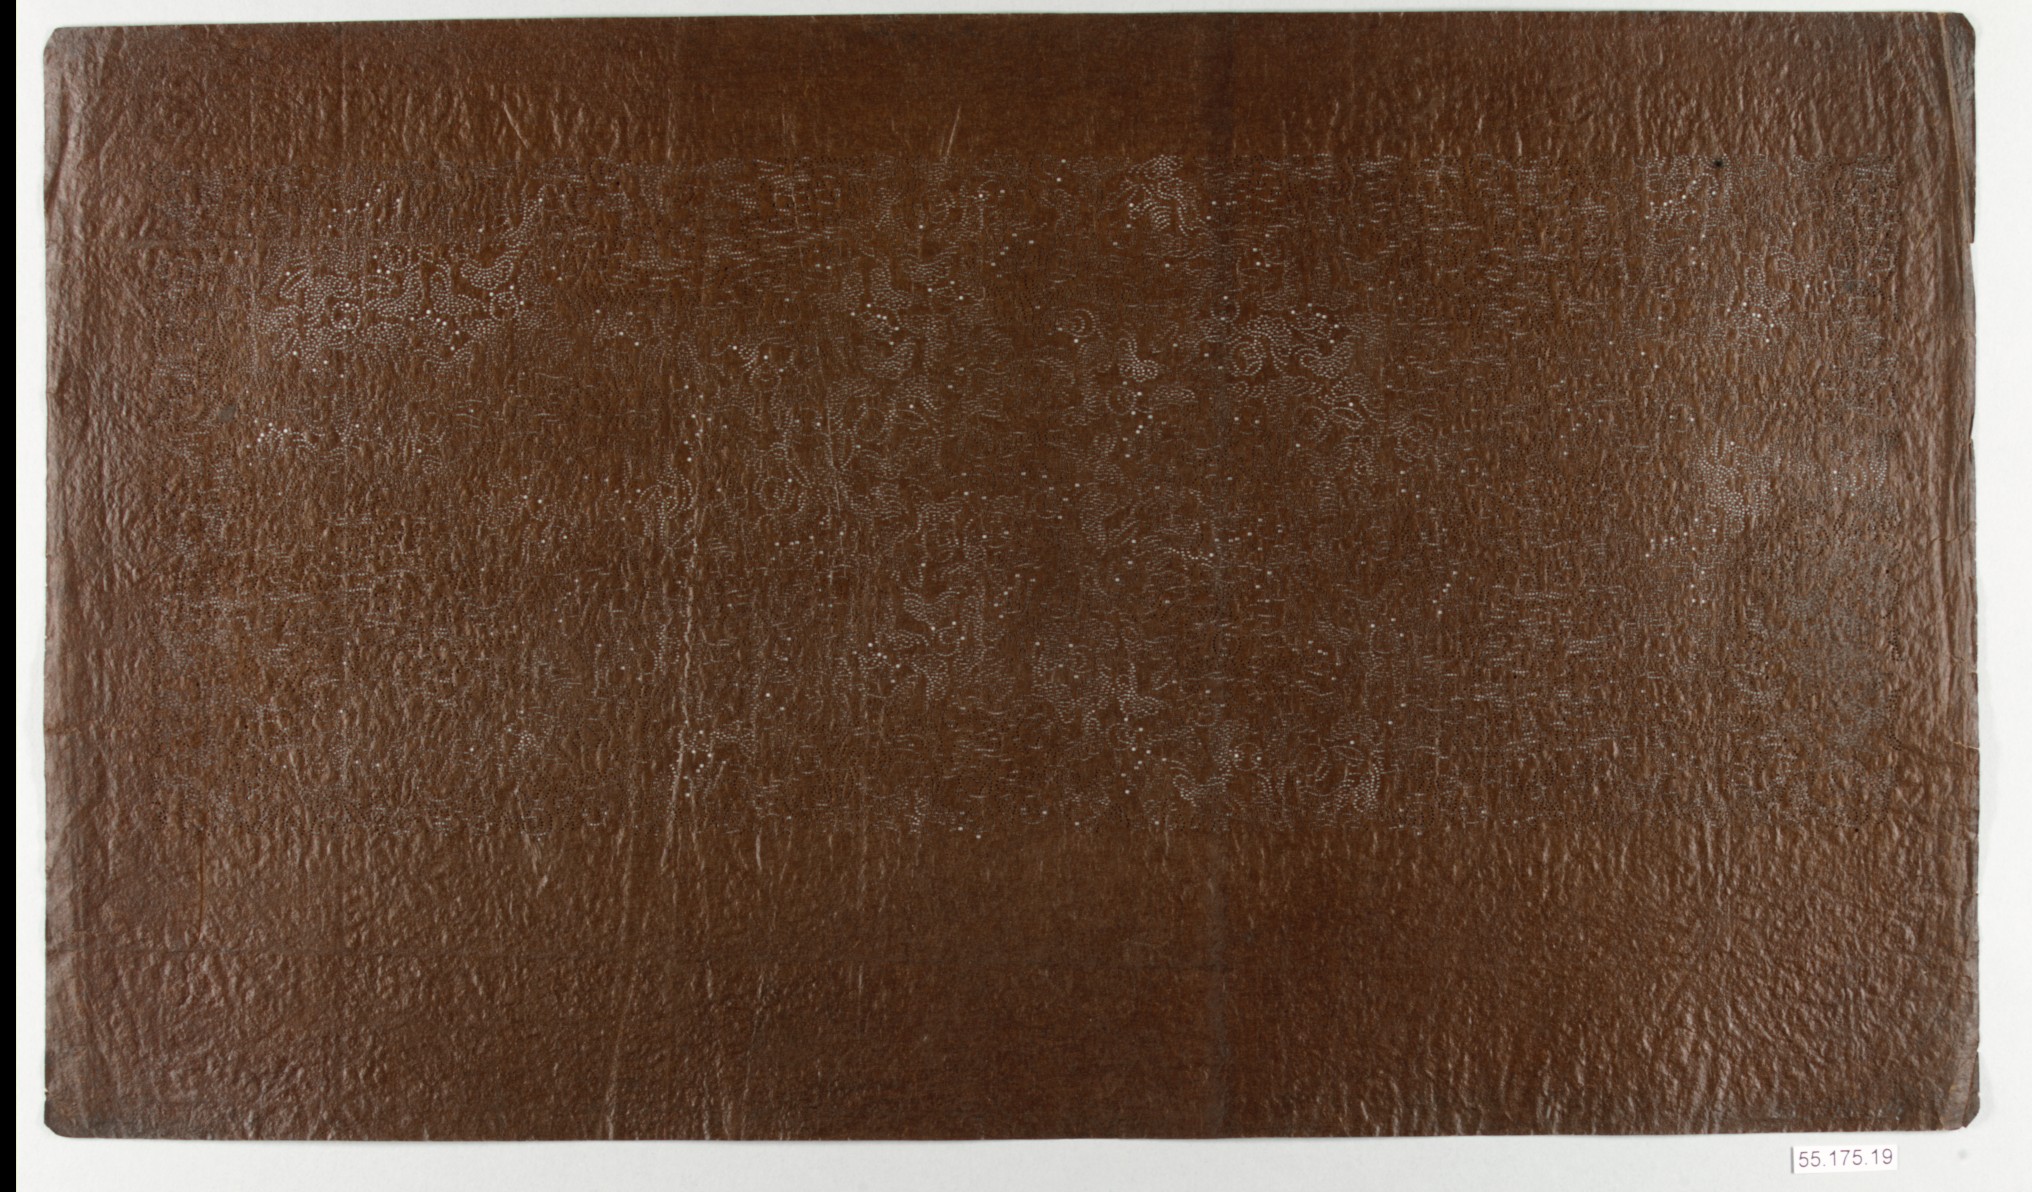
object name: stencil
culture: japanese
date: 1801-1900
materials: paper